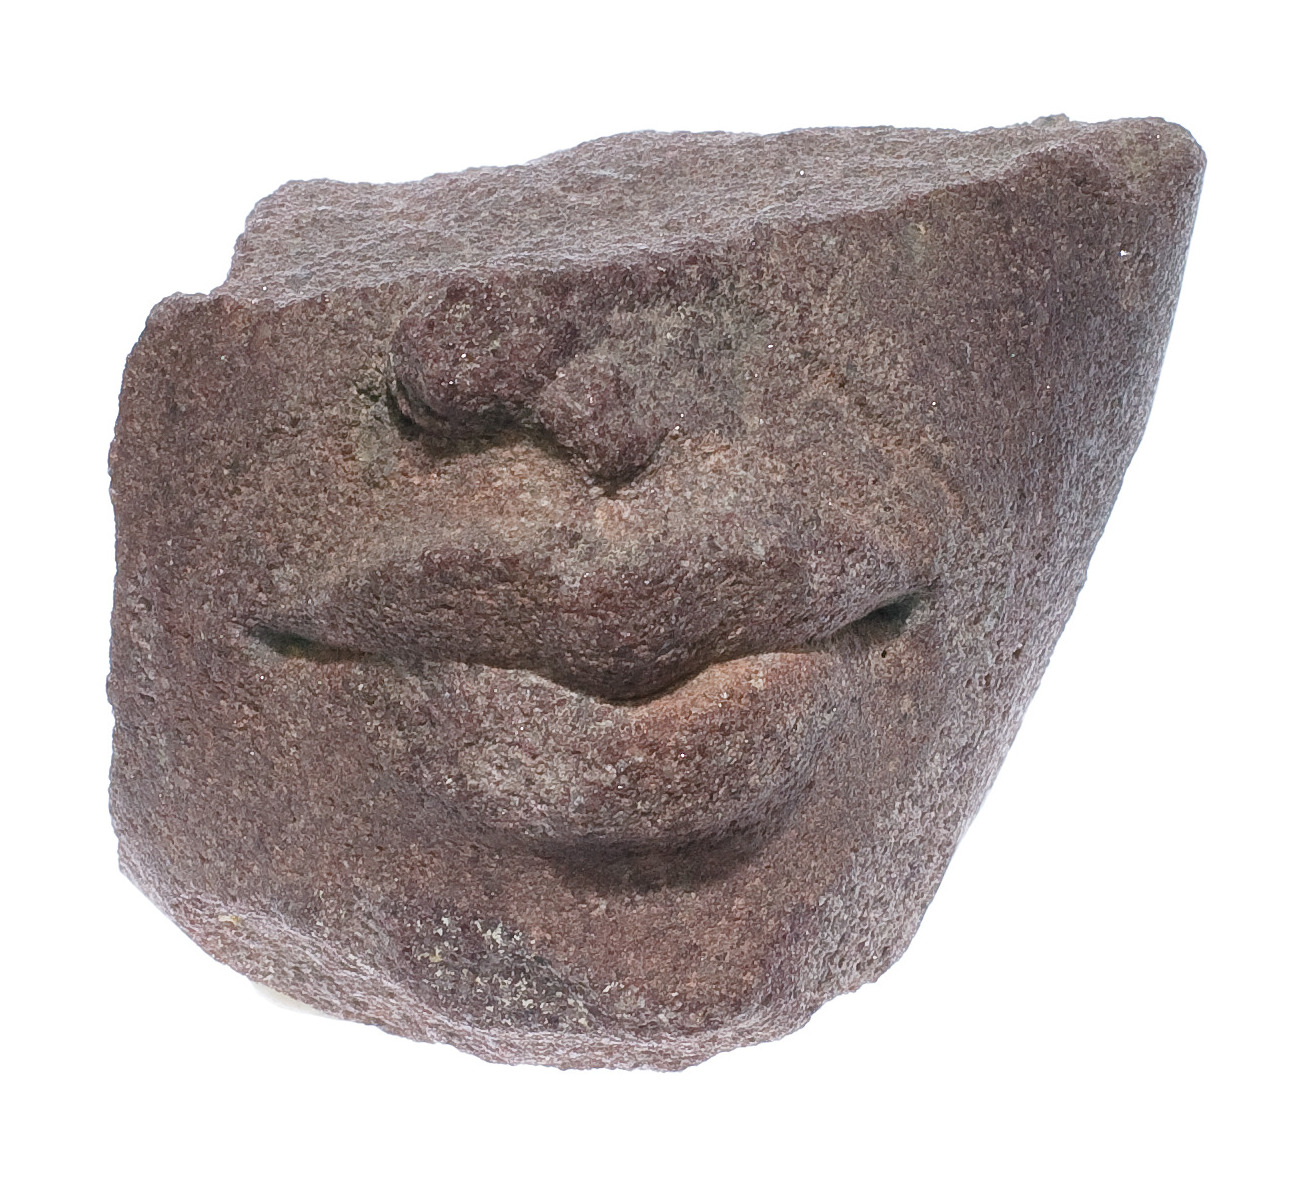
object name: akhenaten or nefertiti, mouth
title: Mouth of Akhenaten or Nefertiti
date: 1353-1336 BCE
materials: quartzite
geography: egypt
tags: mouths